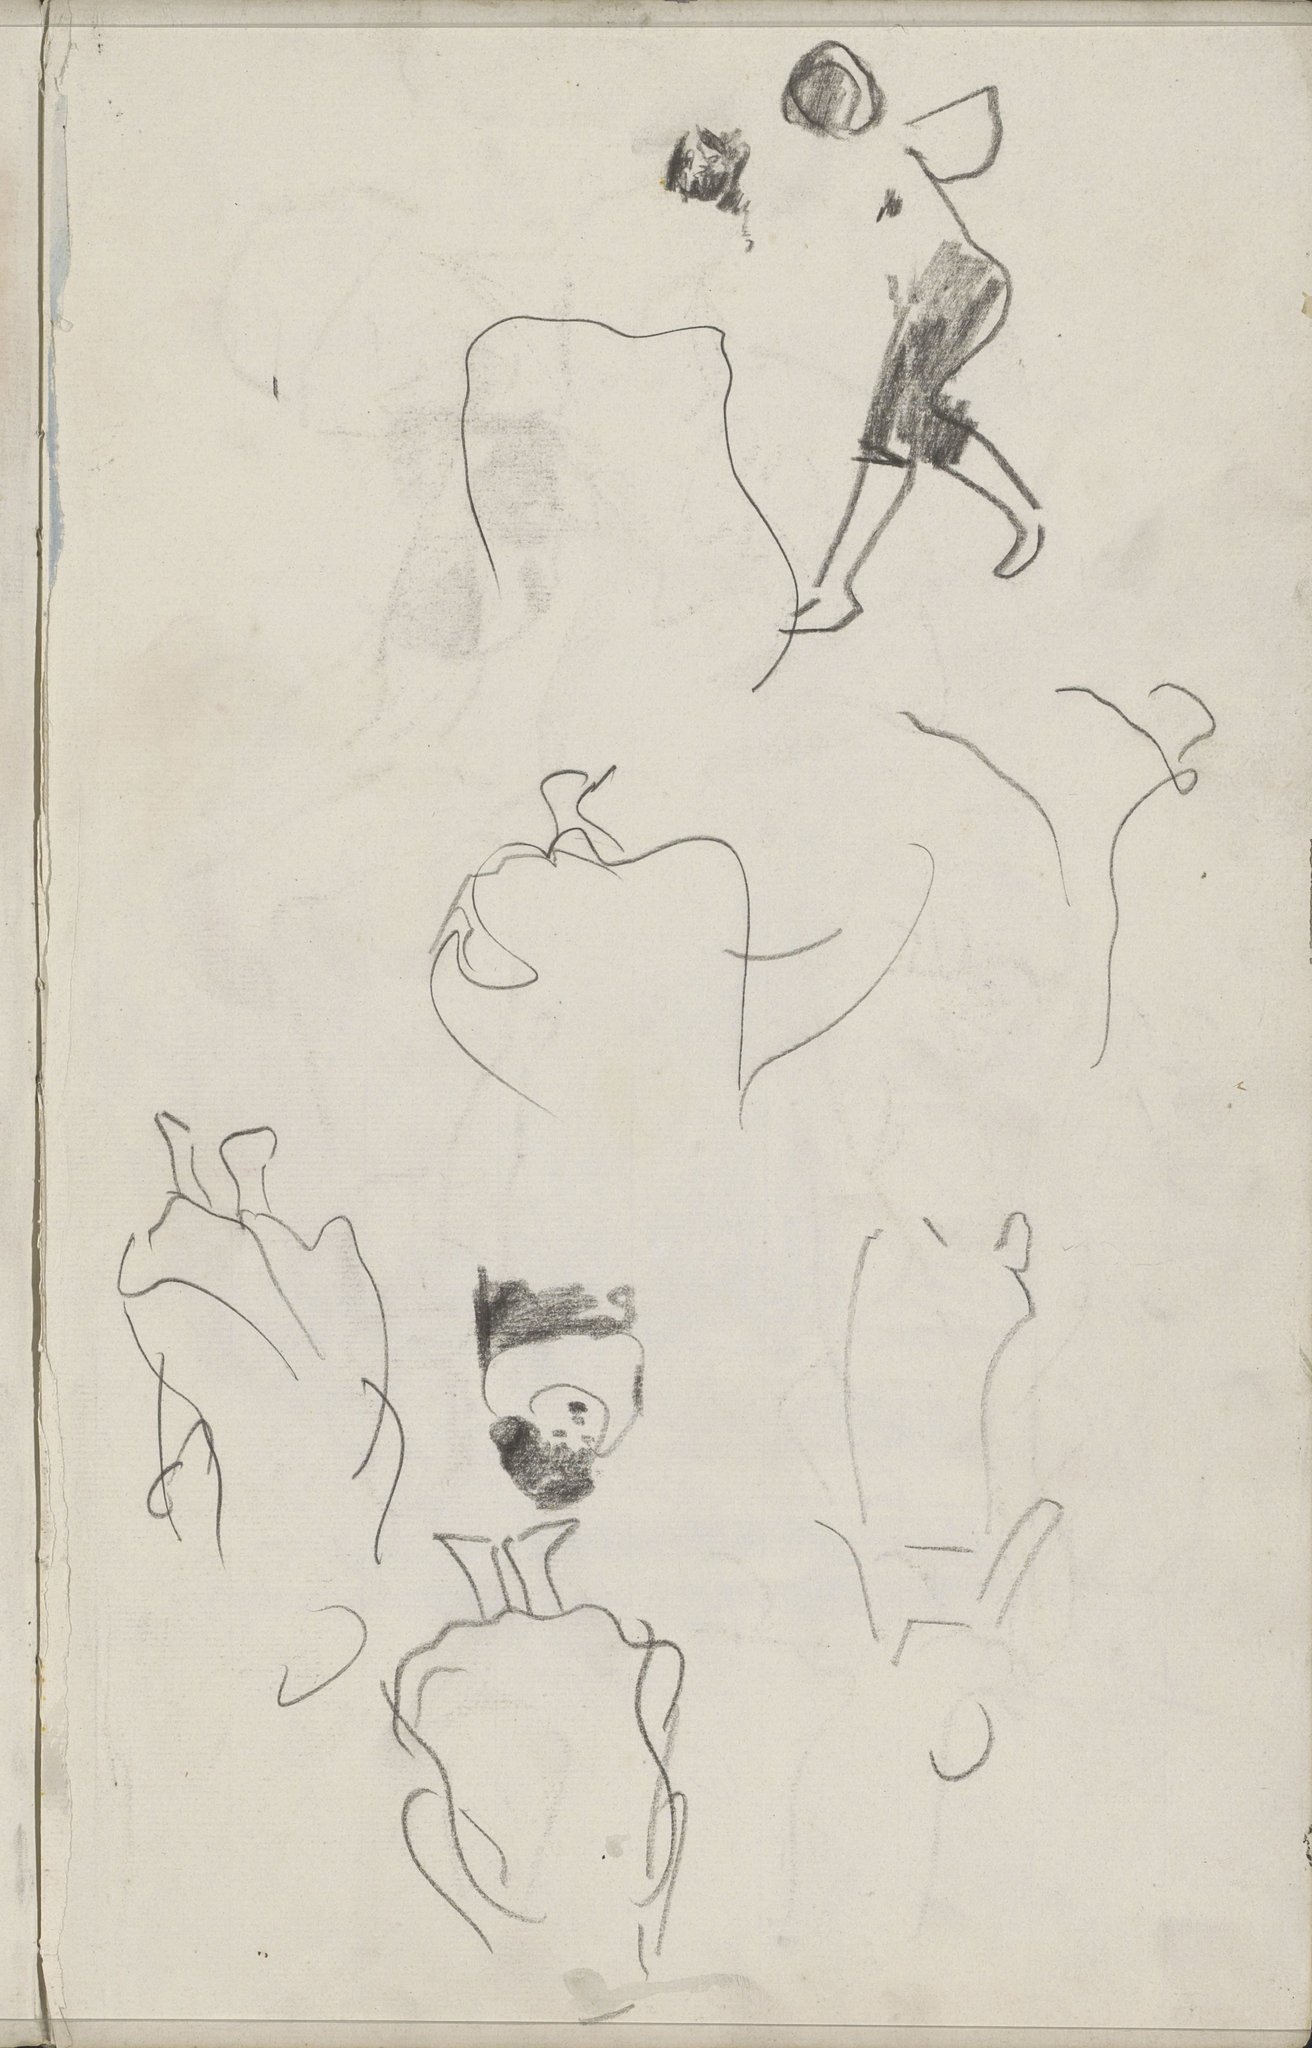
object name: sketchbook leaf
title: Figuurstudies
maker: carel adolph lion cachet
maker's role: draughtsman, print maker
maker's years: 1864-1945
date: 1895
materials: chalk, paper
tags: anatomy (non-medical)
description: Blad 14 recto uit een schetsboek met 23 bladen.